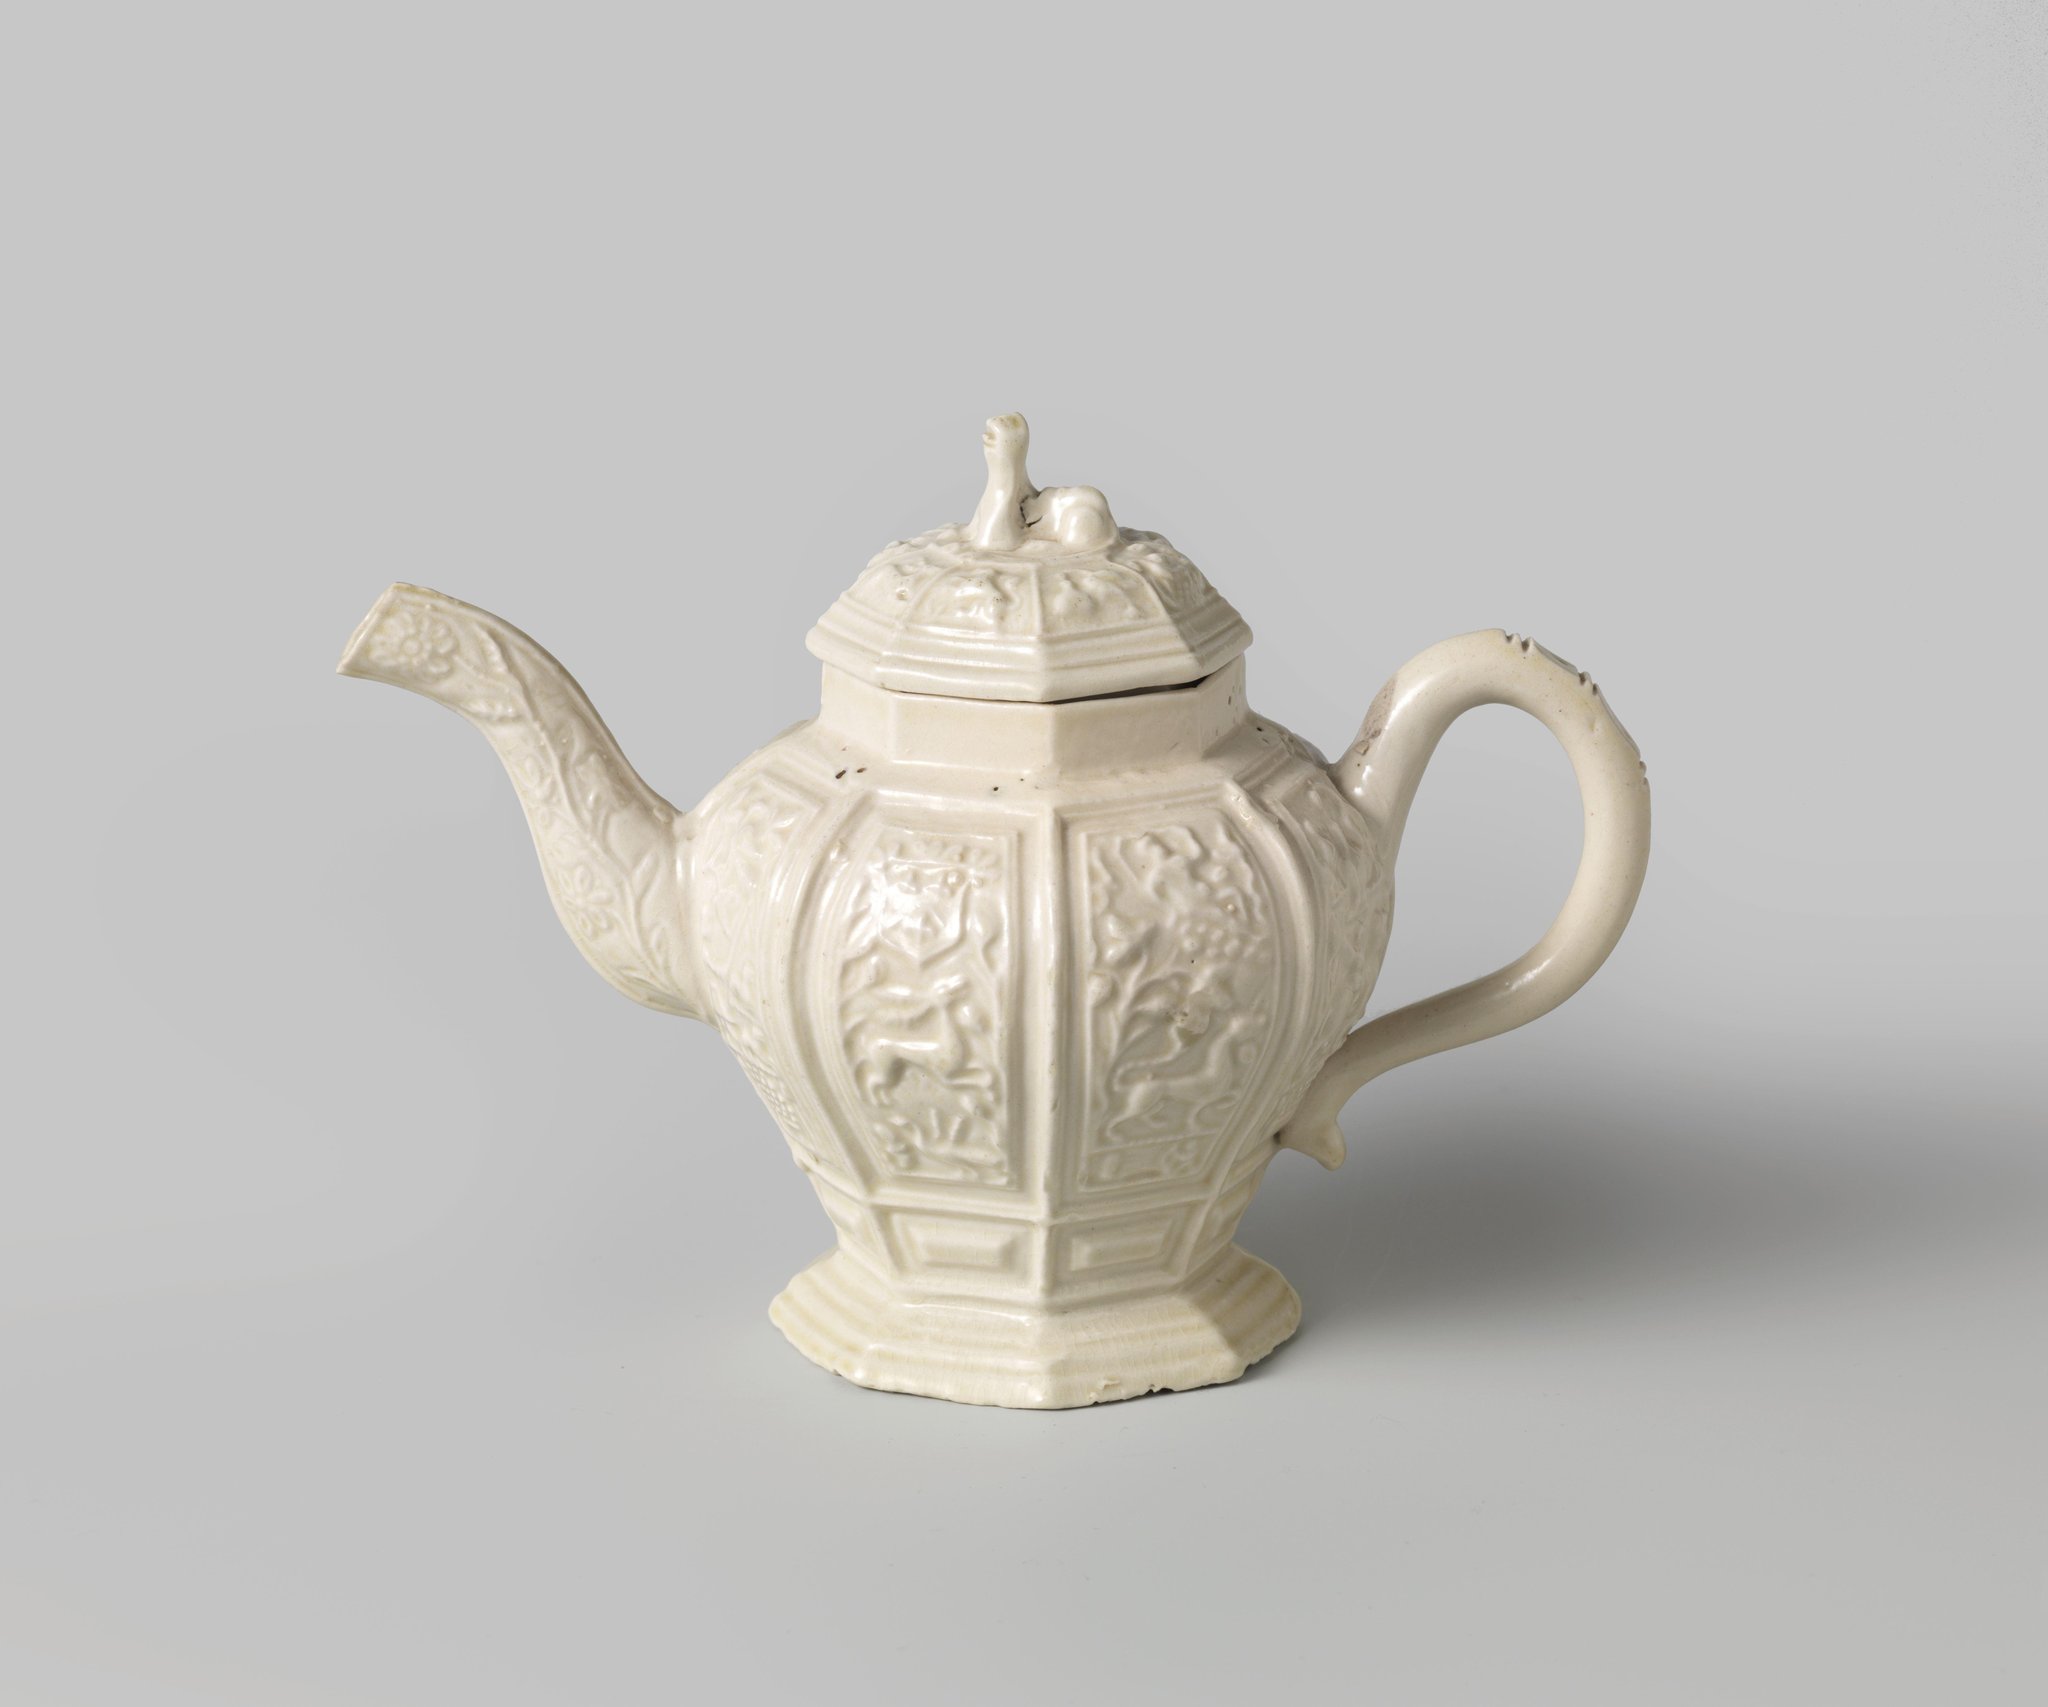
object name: teapot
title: Theepot van steengoed met zoutglazuur; Staffordshire.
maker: Anonymous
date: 1740-1760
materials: stoneware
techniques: salt glaze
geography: england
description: Theepot van steengoed met zoutglazuur. De theepot is achthoekig en heeft op de acht zijden reliëfversieringen, bestaande uit bomen, figuren, dieren en een wapen. De tuit heeft aan beide zijden een bloemtak.